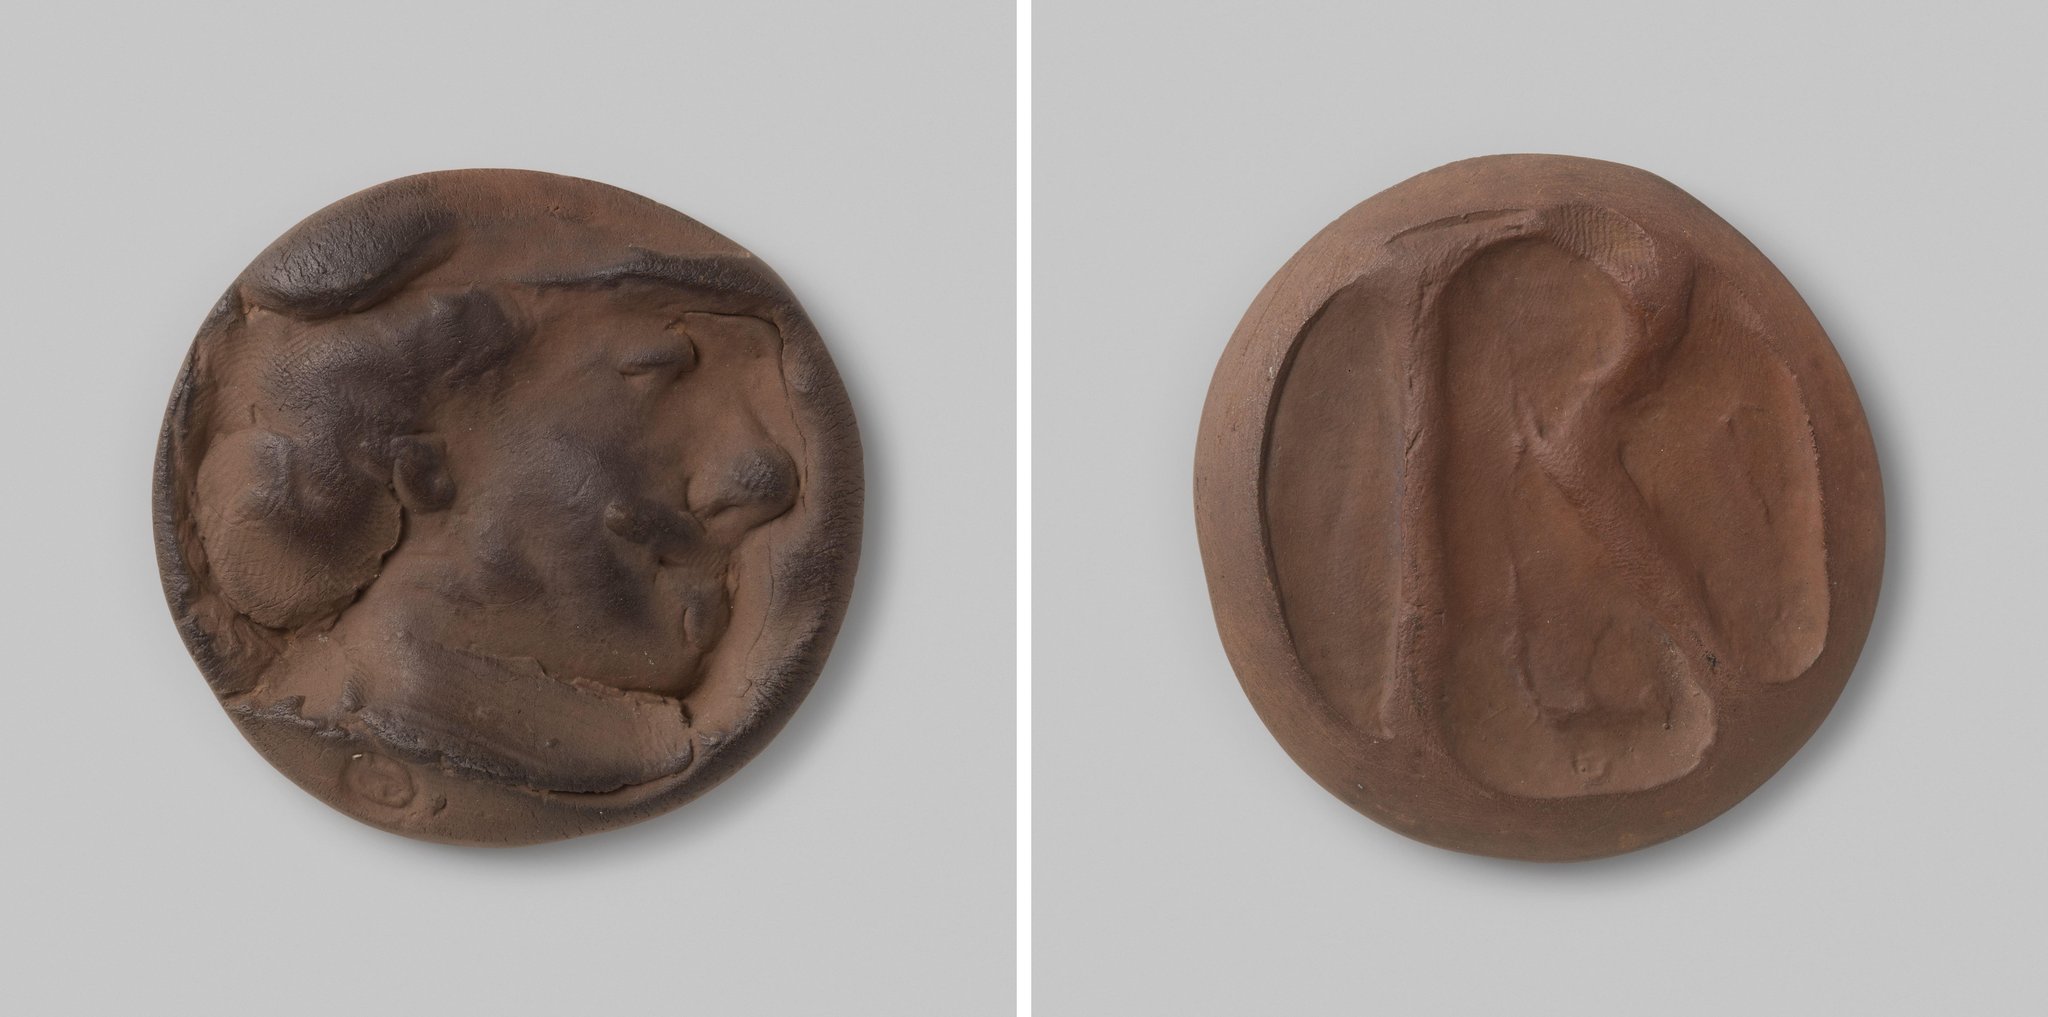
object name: medal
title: Ontwerp voor de Rembrandt penning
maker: vincent pieter semeyn esser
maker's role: hoogleraar, medailleur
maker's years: 1914-2004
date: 1988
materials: cardboard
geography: netherlands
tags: leiden, amsterdam, painter, print maker, draughtsman, rembrandt van rijn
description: Biscuit van het ontwerp van de Rembrandt penning. Voorzijde: het hoofd van Rembrandt. Keerzijde de letter R. Verpakt in blauw kartonnen doosje.